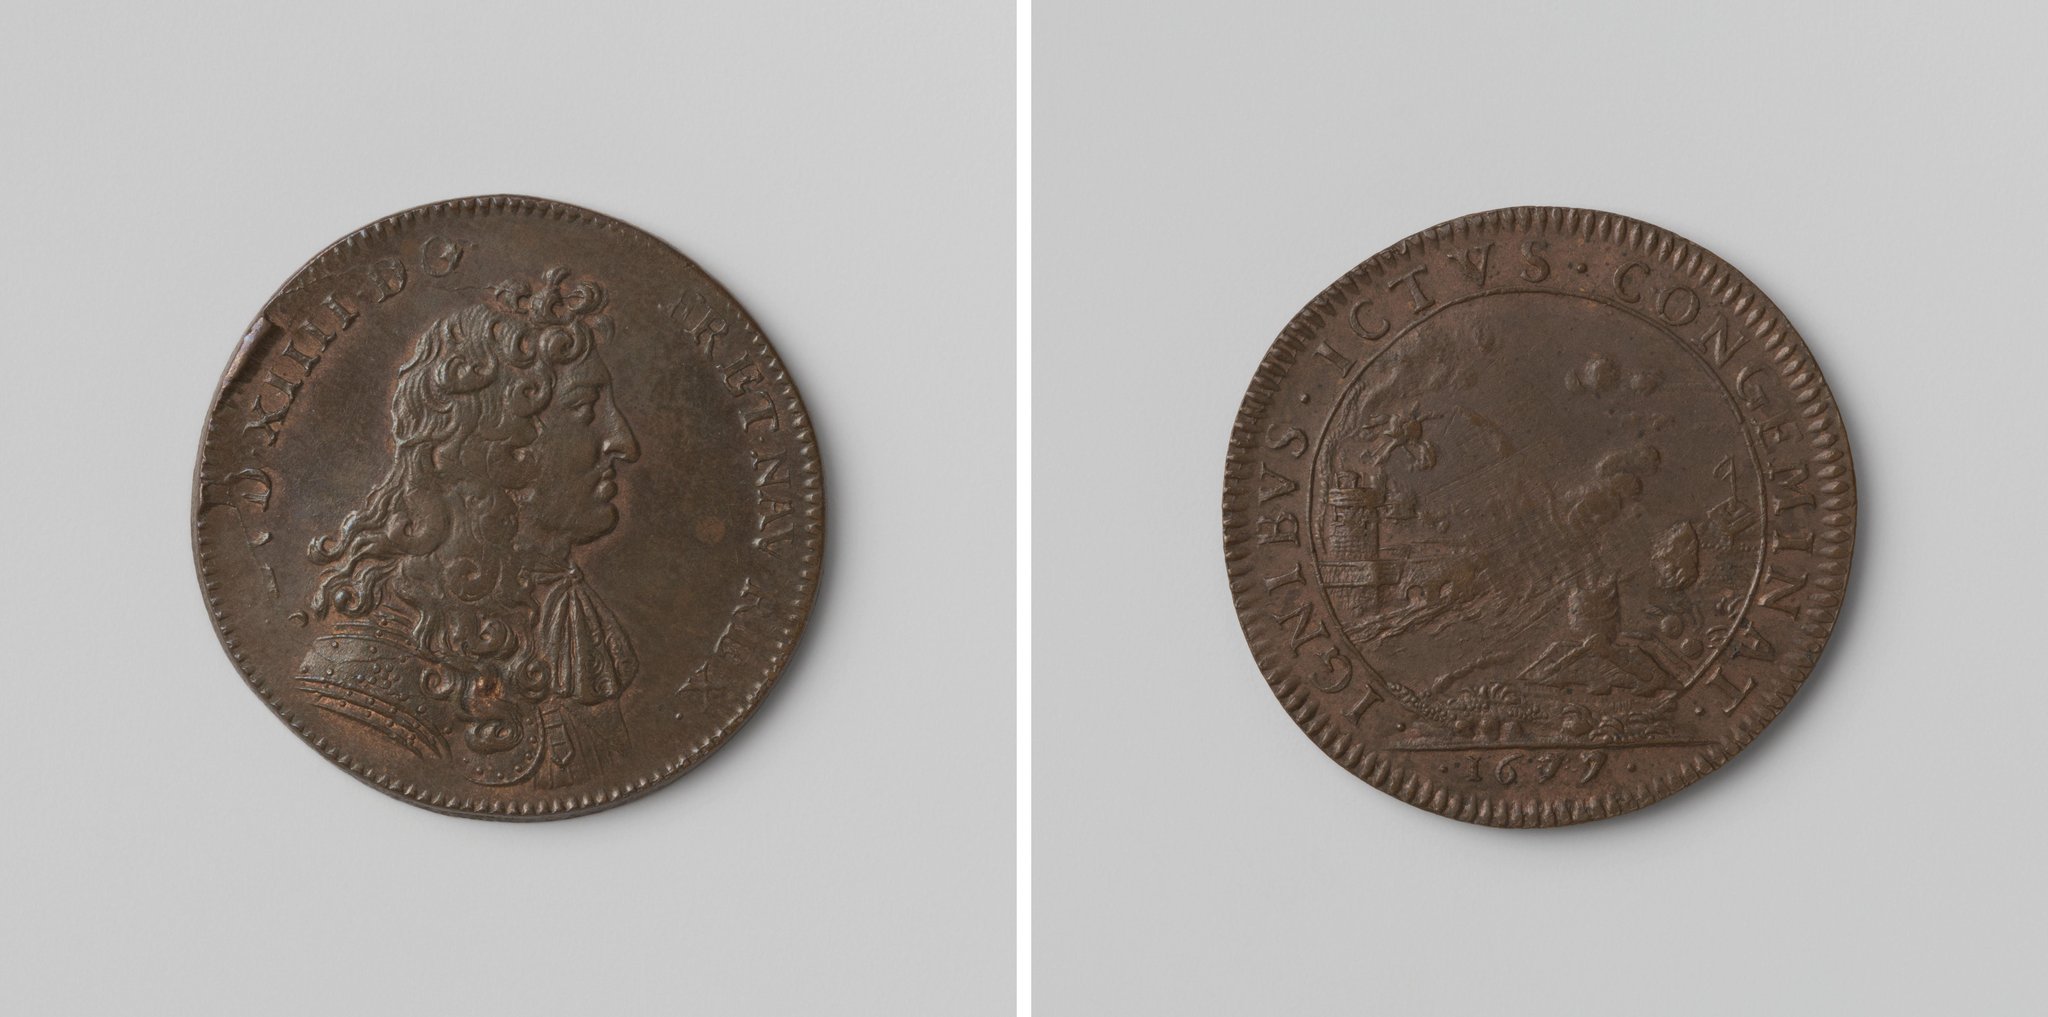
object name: jeton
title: Verovering van Tobago, rekenpenning geslagen ter ere van Lodewijk XIV, koning van Frankrijk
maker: Anonymous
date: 1677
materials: copper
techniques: striking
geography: france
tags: lodewijk xiv (koning van frankrijk)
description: Koperen penning. Voorzijde: borststuk man binnen omschrift. Keerzijde: mortier, die stad Tobago beschiet binnen omschrift; afsnede: jaartal